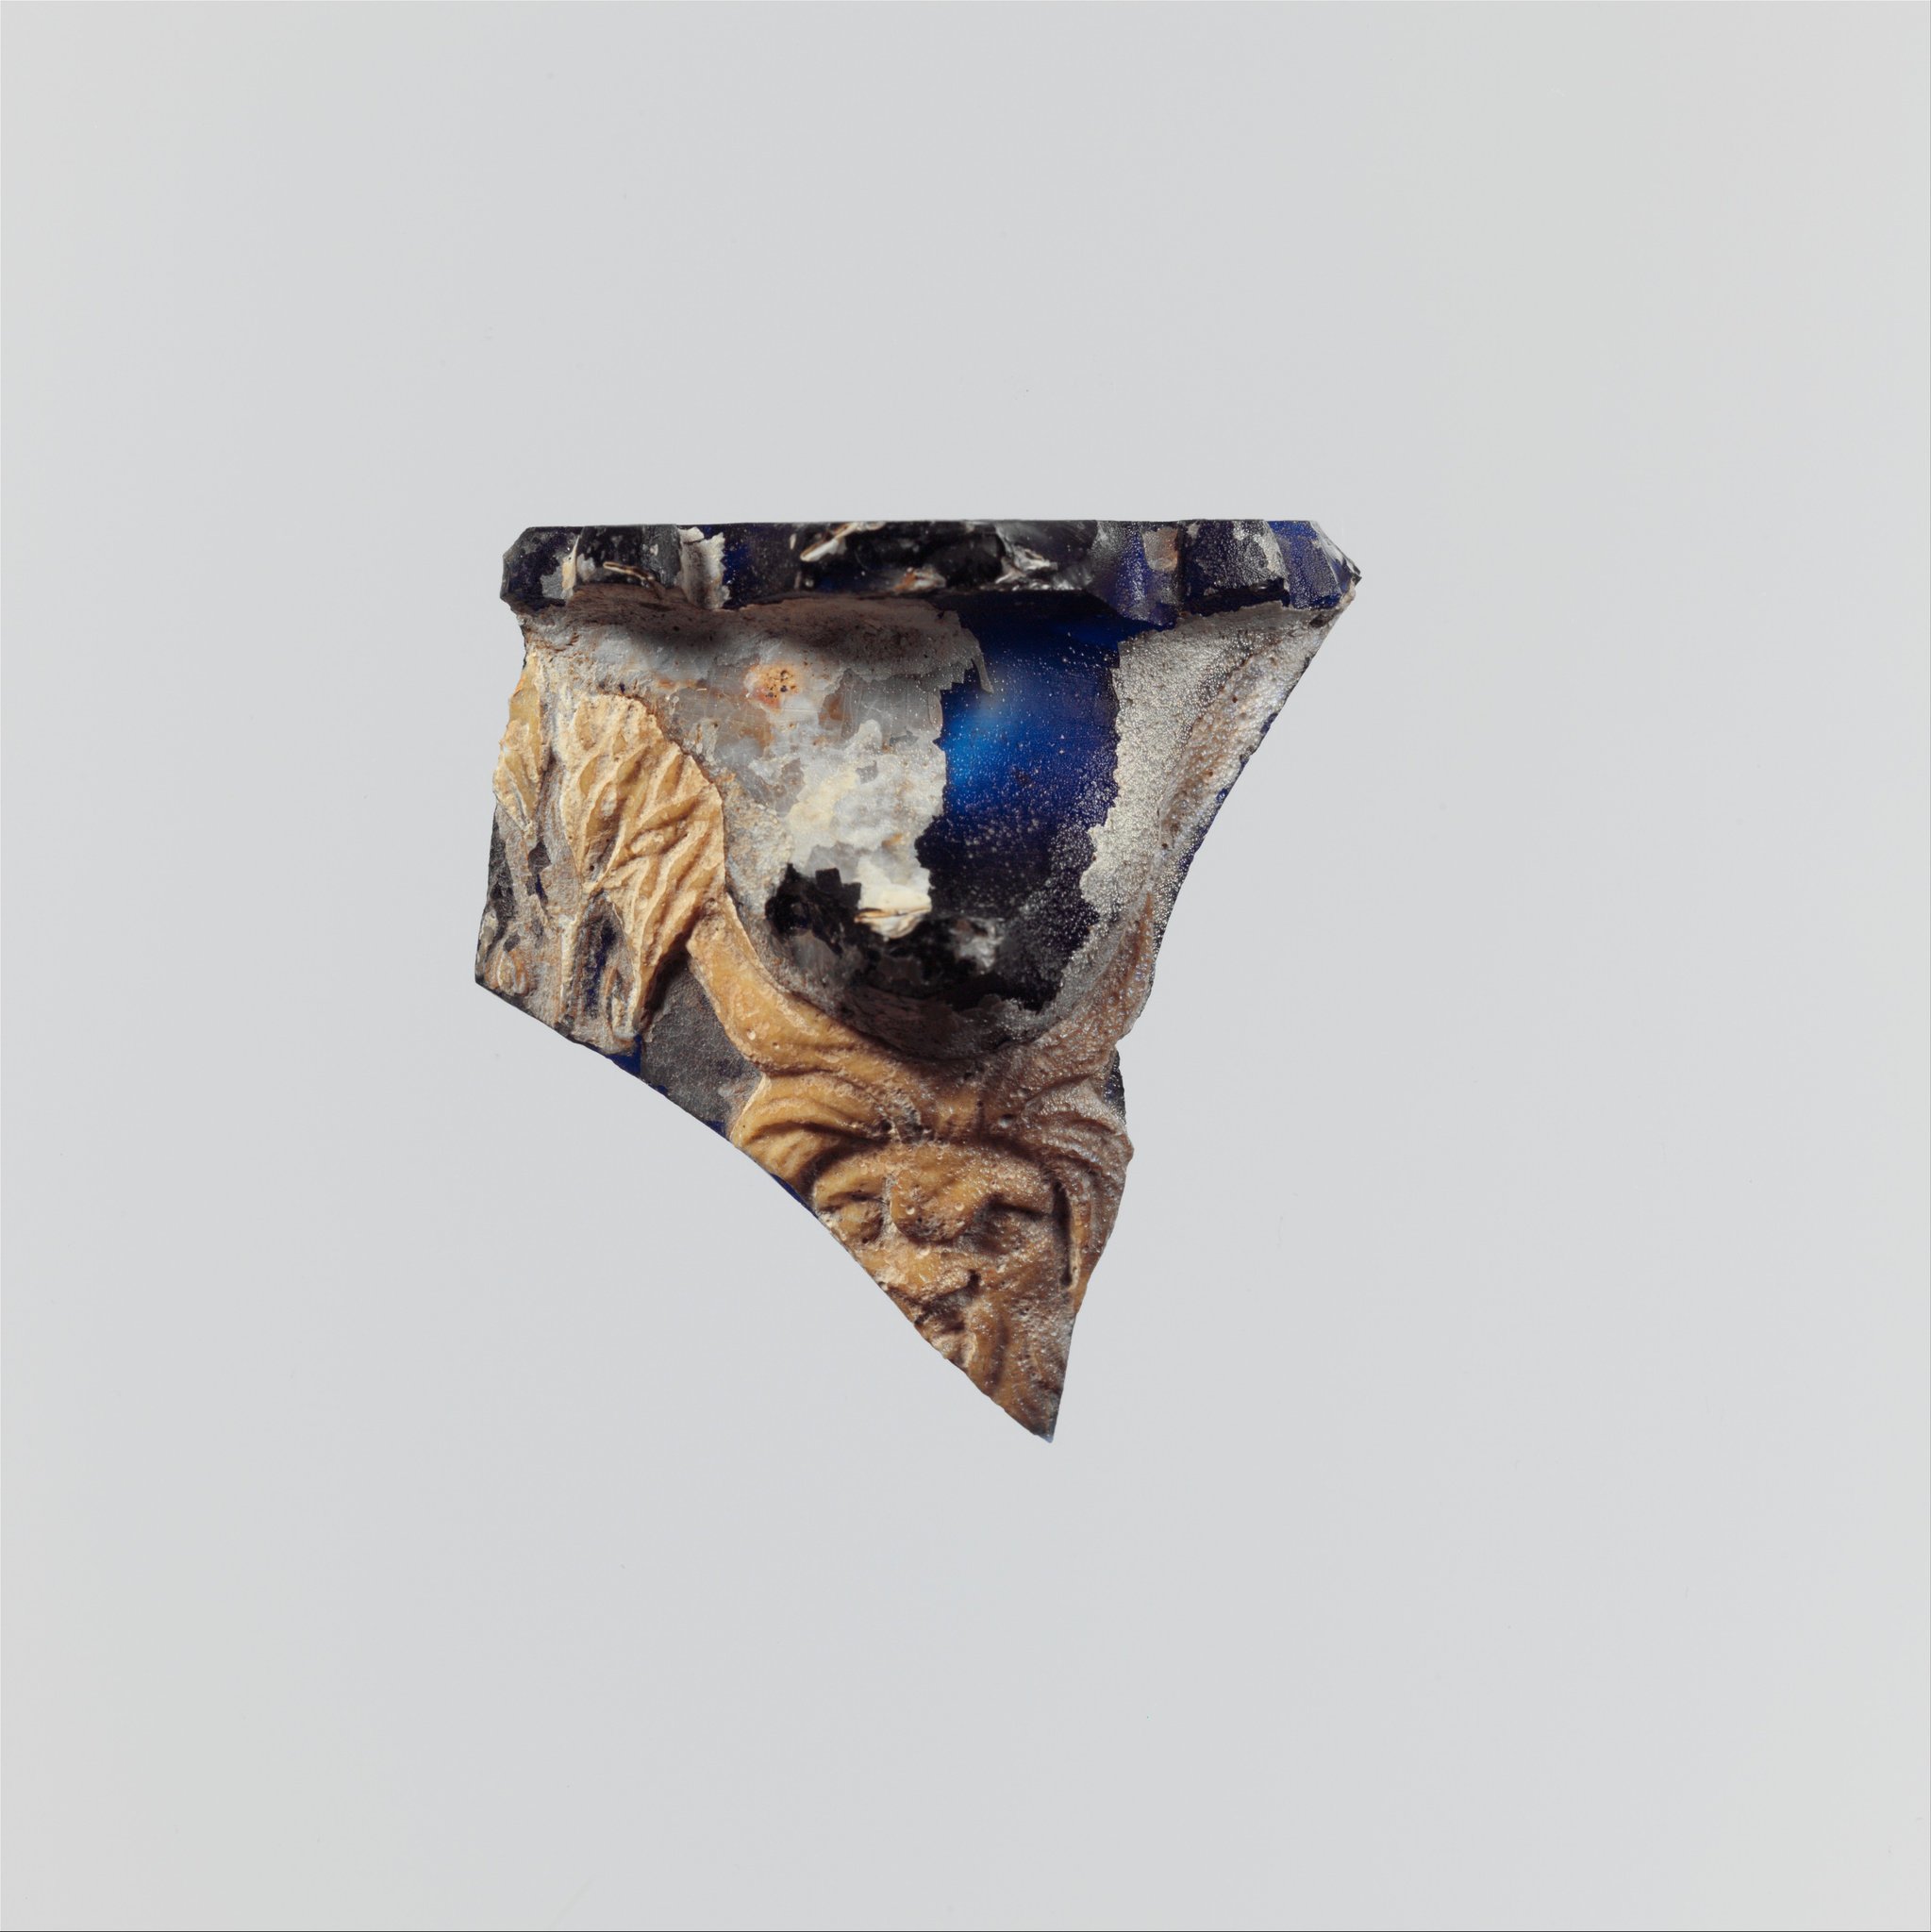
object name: cameo, cup fragment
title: Glass cameo cup (scyphus) fragment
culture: roman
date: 67-100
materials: glass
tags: faces